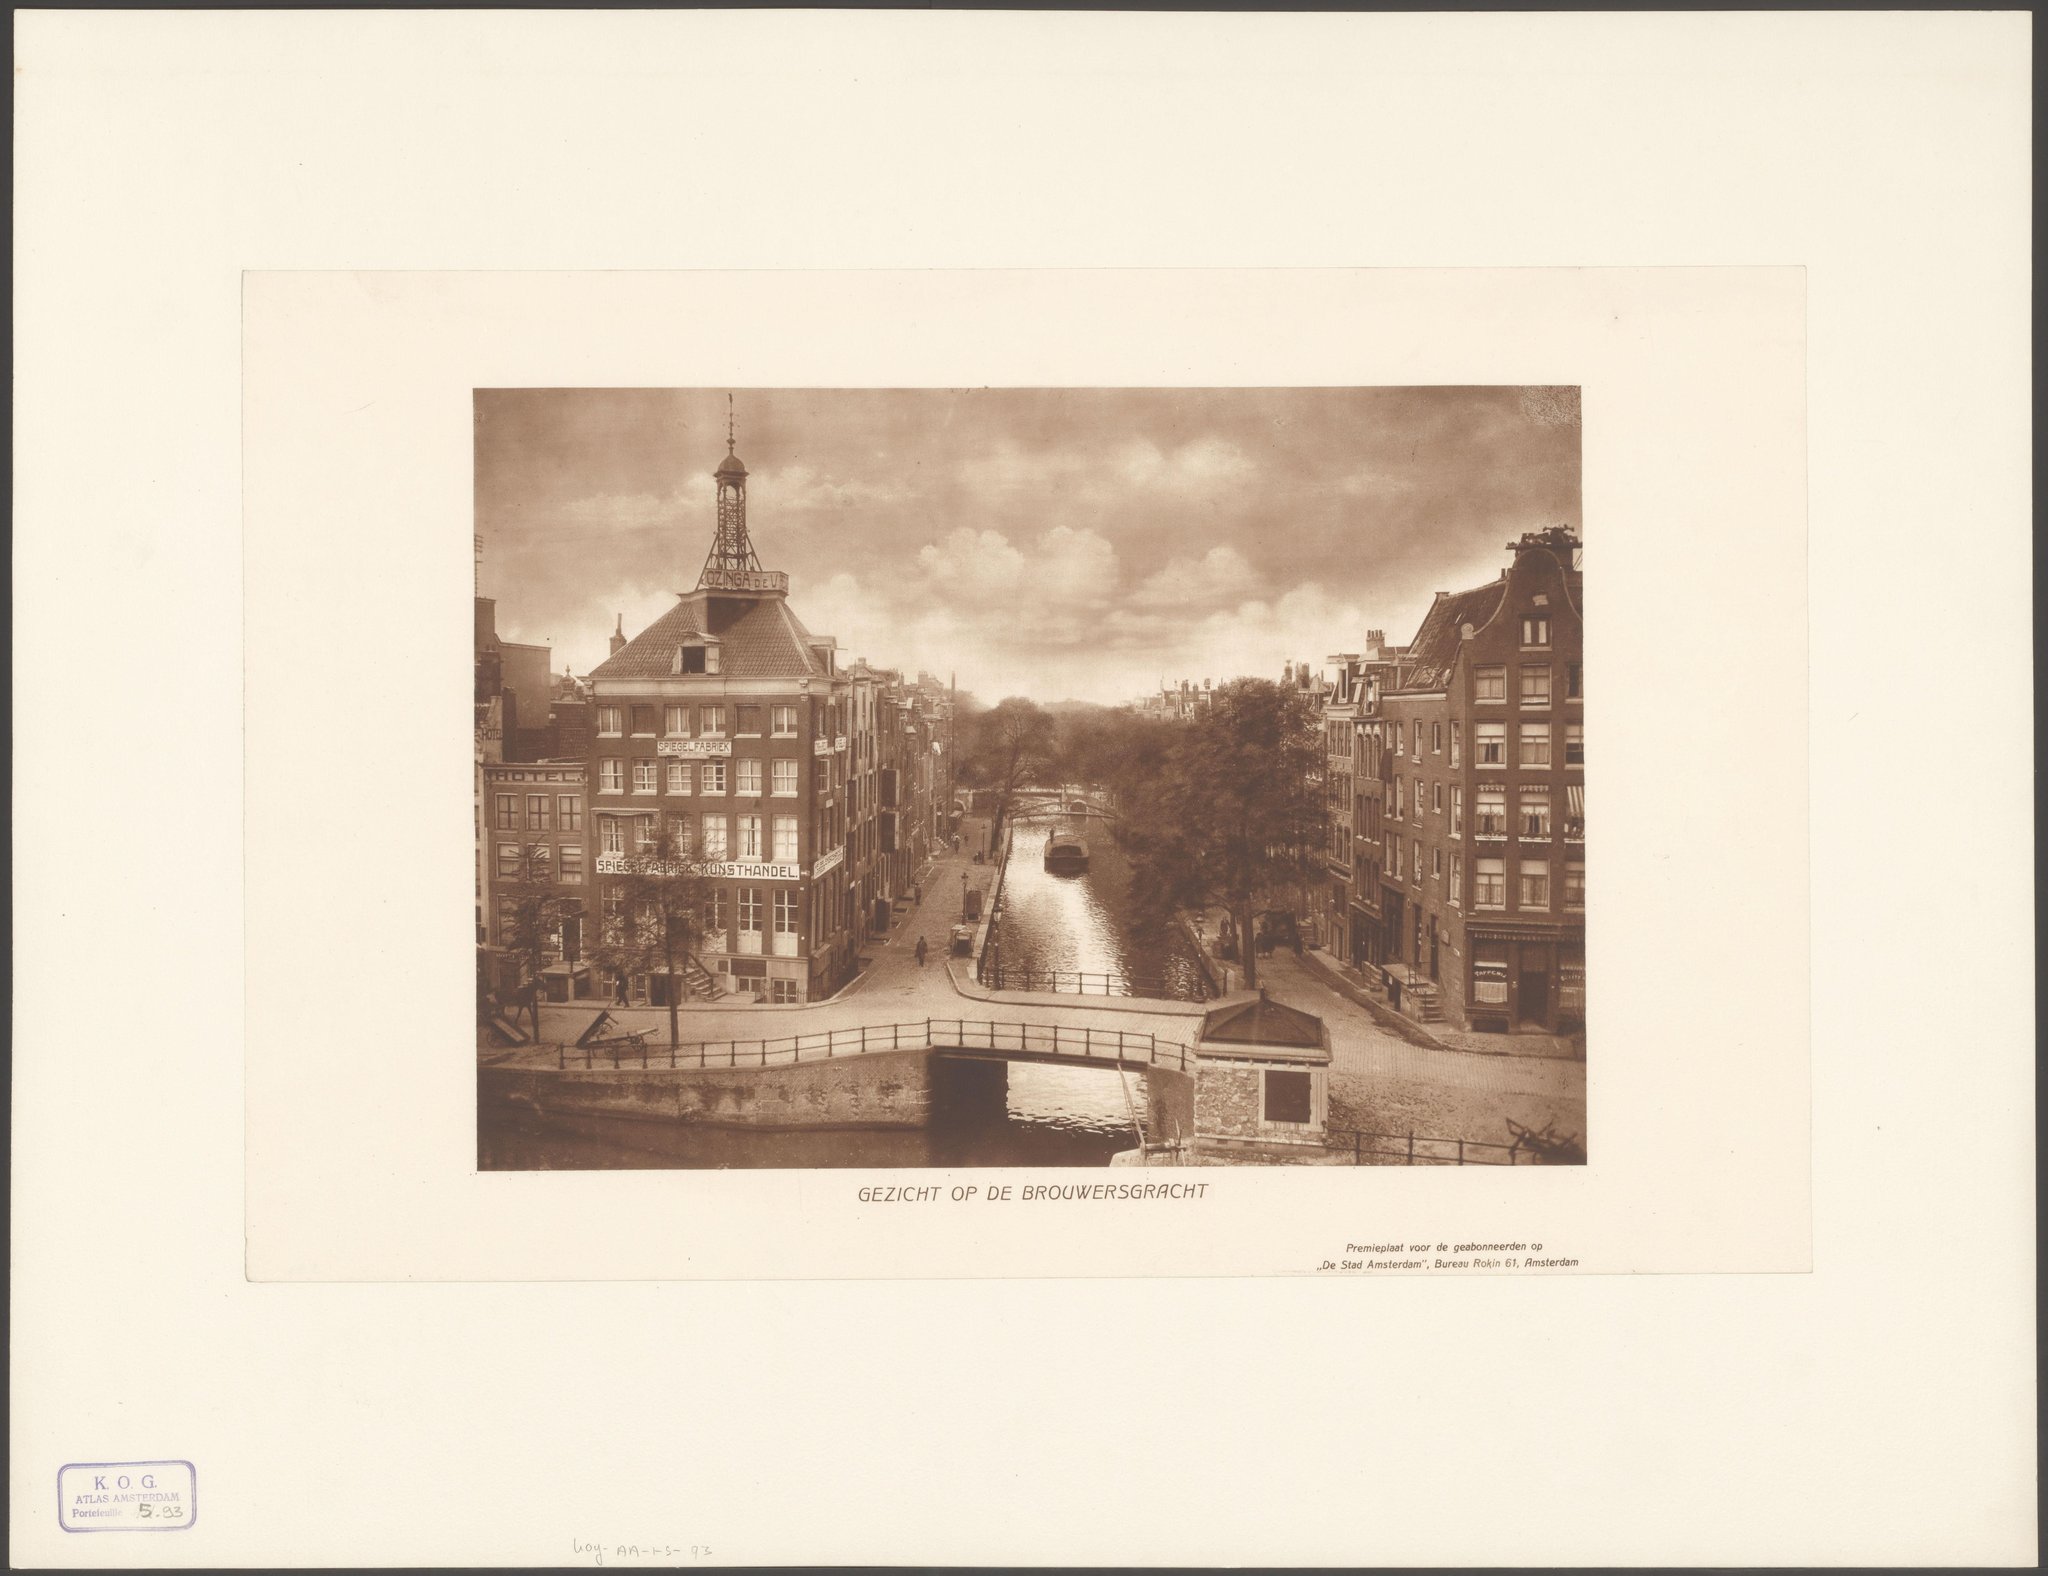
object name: photomechanical print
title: Gezicht op de Brouwersgracht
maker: Anonymous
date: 1895-1950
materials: paper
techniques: rotogravure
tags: city-view in general; 'veduta', canal, the usual house or row of houses, bridge in city across river, canal, etc., street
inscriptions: collector's mark: ‘5.93’ Lugt 1641b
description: Onderwerpsrubriek binnen de Atlas Amsterdam: Begijnensloot (Gedempte), Bagijnhofsteeg, Beulingsloot, Bickersgracht en –plein, Bickersstraat (Groote), Bilderdijkskade en -straat, Binnenkant, Blauwburgwal, Boomdwarsstraat, Brouwersgracht, Bleekersspad (Lange), Bleekerssloot, Bloemgracht, Boerenwetering, Boltensgrachtje, Boomssloot (Recht), Badhuisweg.